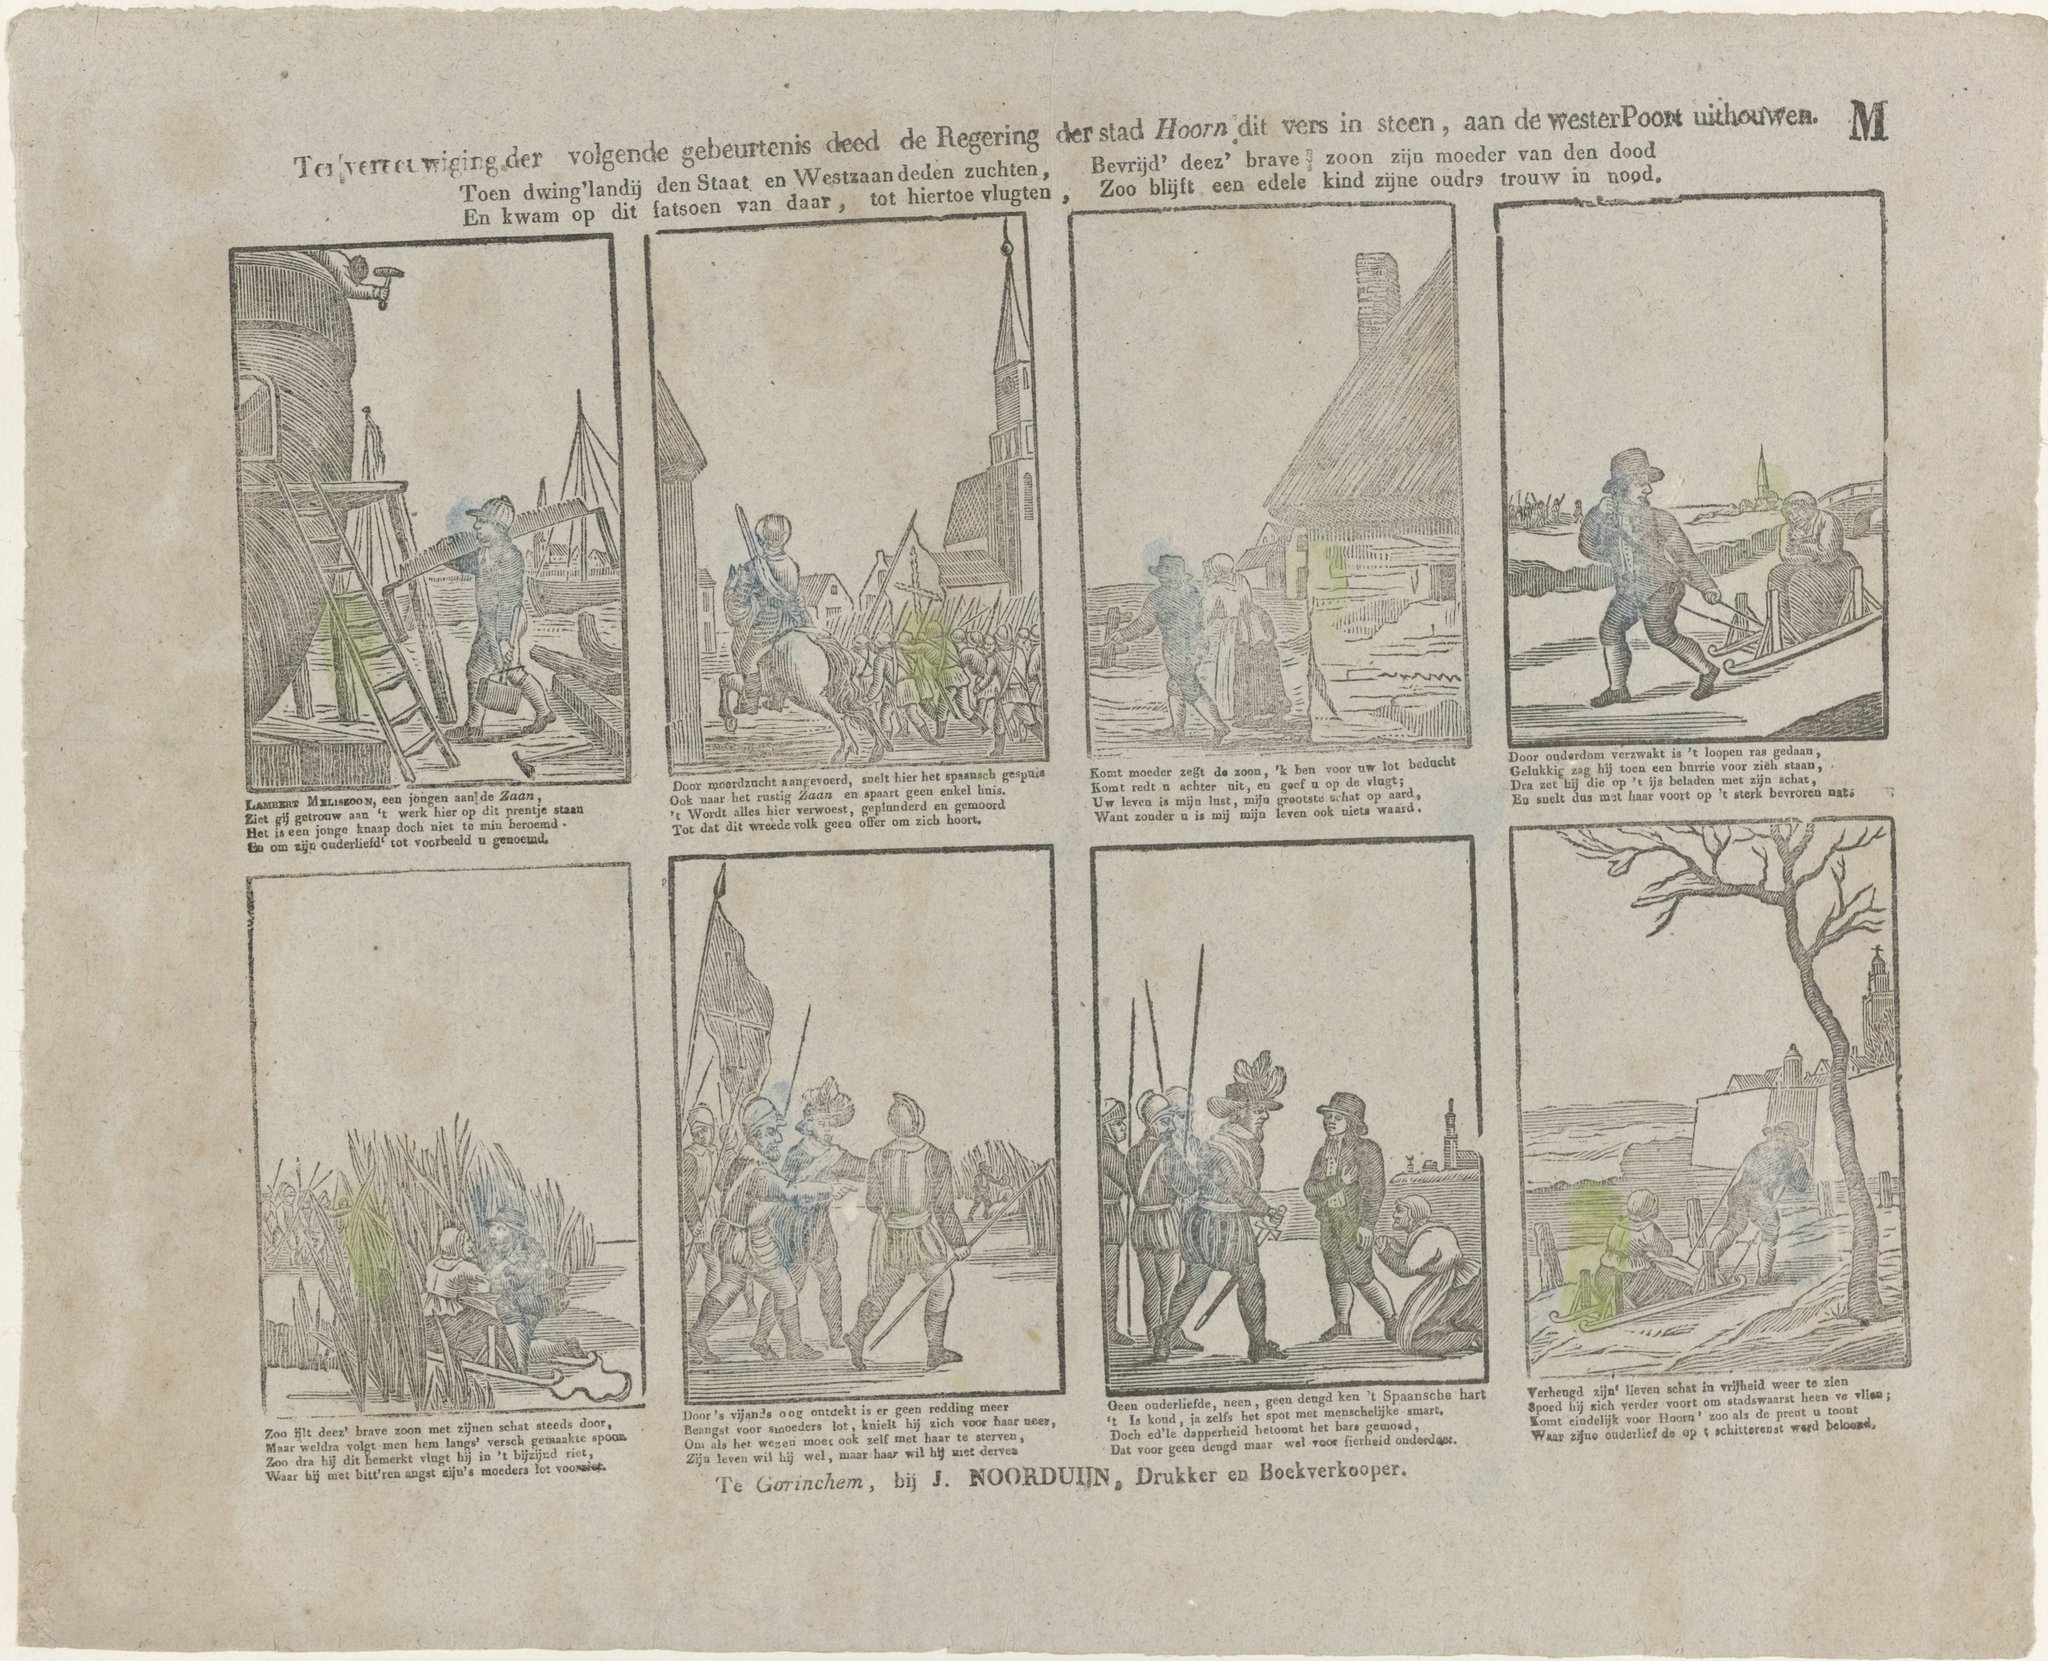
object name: print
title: Ter vereeuwiging der volgende gebeurtenis deed de regering der stad Hoorn dit vers in steen, aan de westerpoort uithouwen (...)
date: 1819-1840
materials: paper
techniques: colour, letterpress printing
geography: gorinchem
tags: flight, running away; pursuing, hiding, hiding oneself, hoorn (north holland)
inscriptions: collector's mark: Lugt 2760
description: Blad met 8 voorstellingen over Lambert Melisz. Lambert Melisz uit Zaandam zette in februari 1574 zijn oude slecht lopende moeder op een slee en vluchtte met haar in de barre kou over het ijs. Onderweg werden zij betrapt door de Spanjaarden. Toen de soldaten de jongen met zijn onder dekens verstopte huiverende moeder aantroffen werden zij daardoor zo geroerd dat de twee ongemoeid werden gelaten. Na een barre tocht bereikte Lambert Meliszoon met zijn moeder veilig de poorten van Hoorn. Onder elke afbeelding een vierregelig vers. Gemerkt rechtsboven: M.